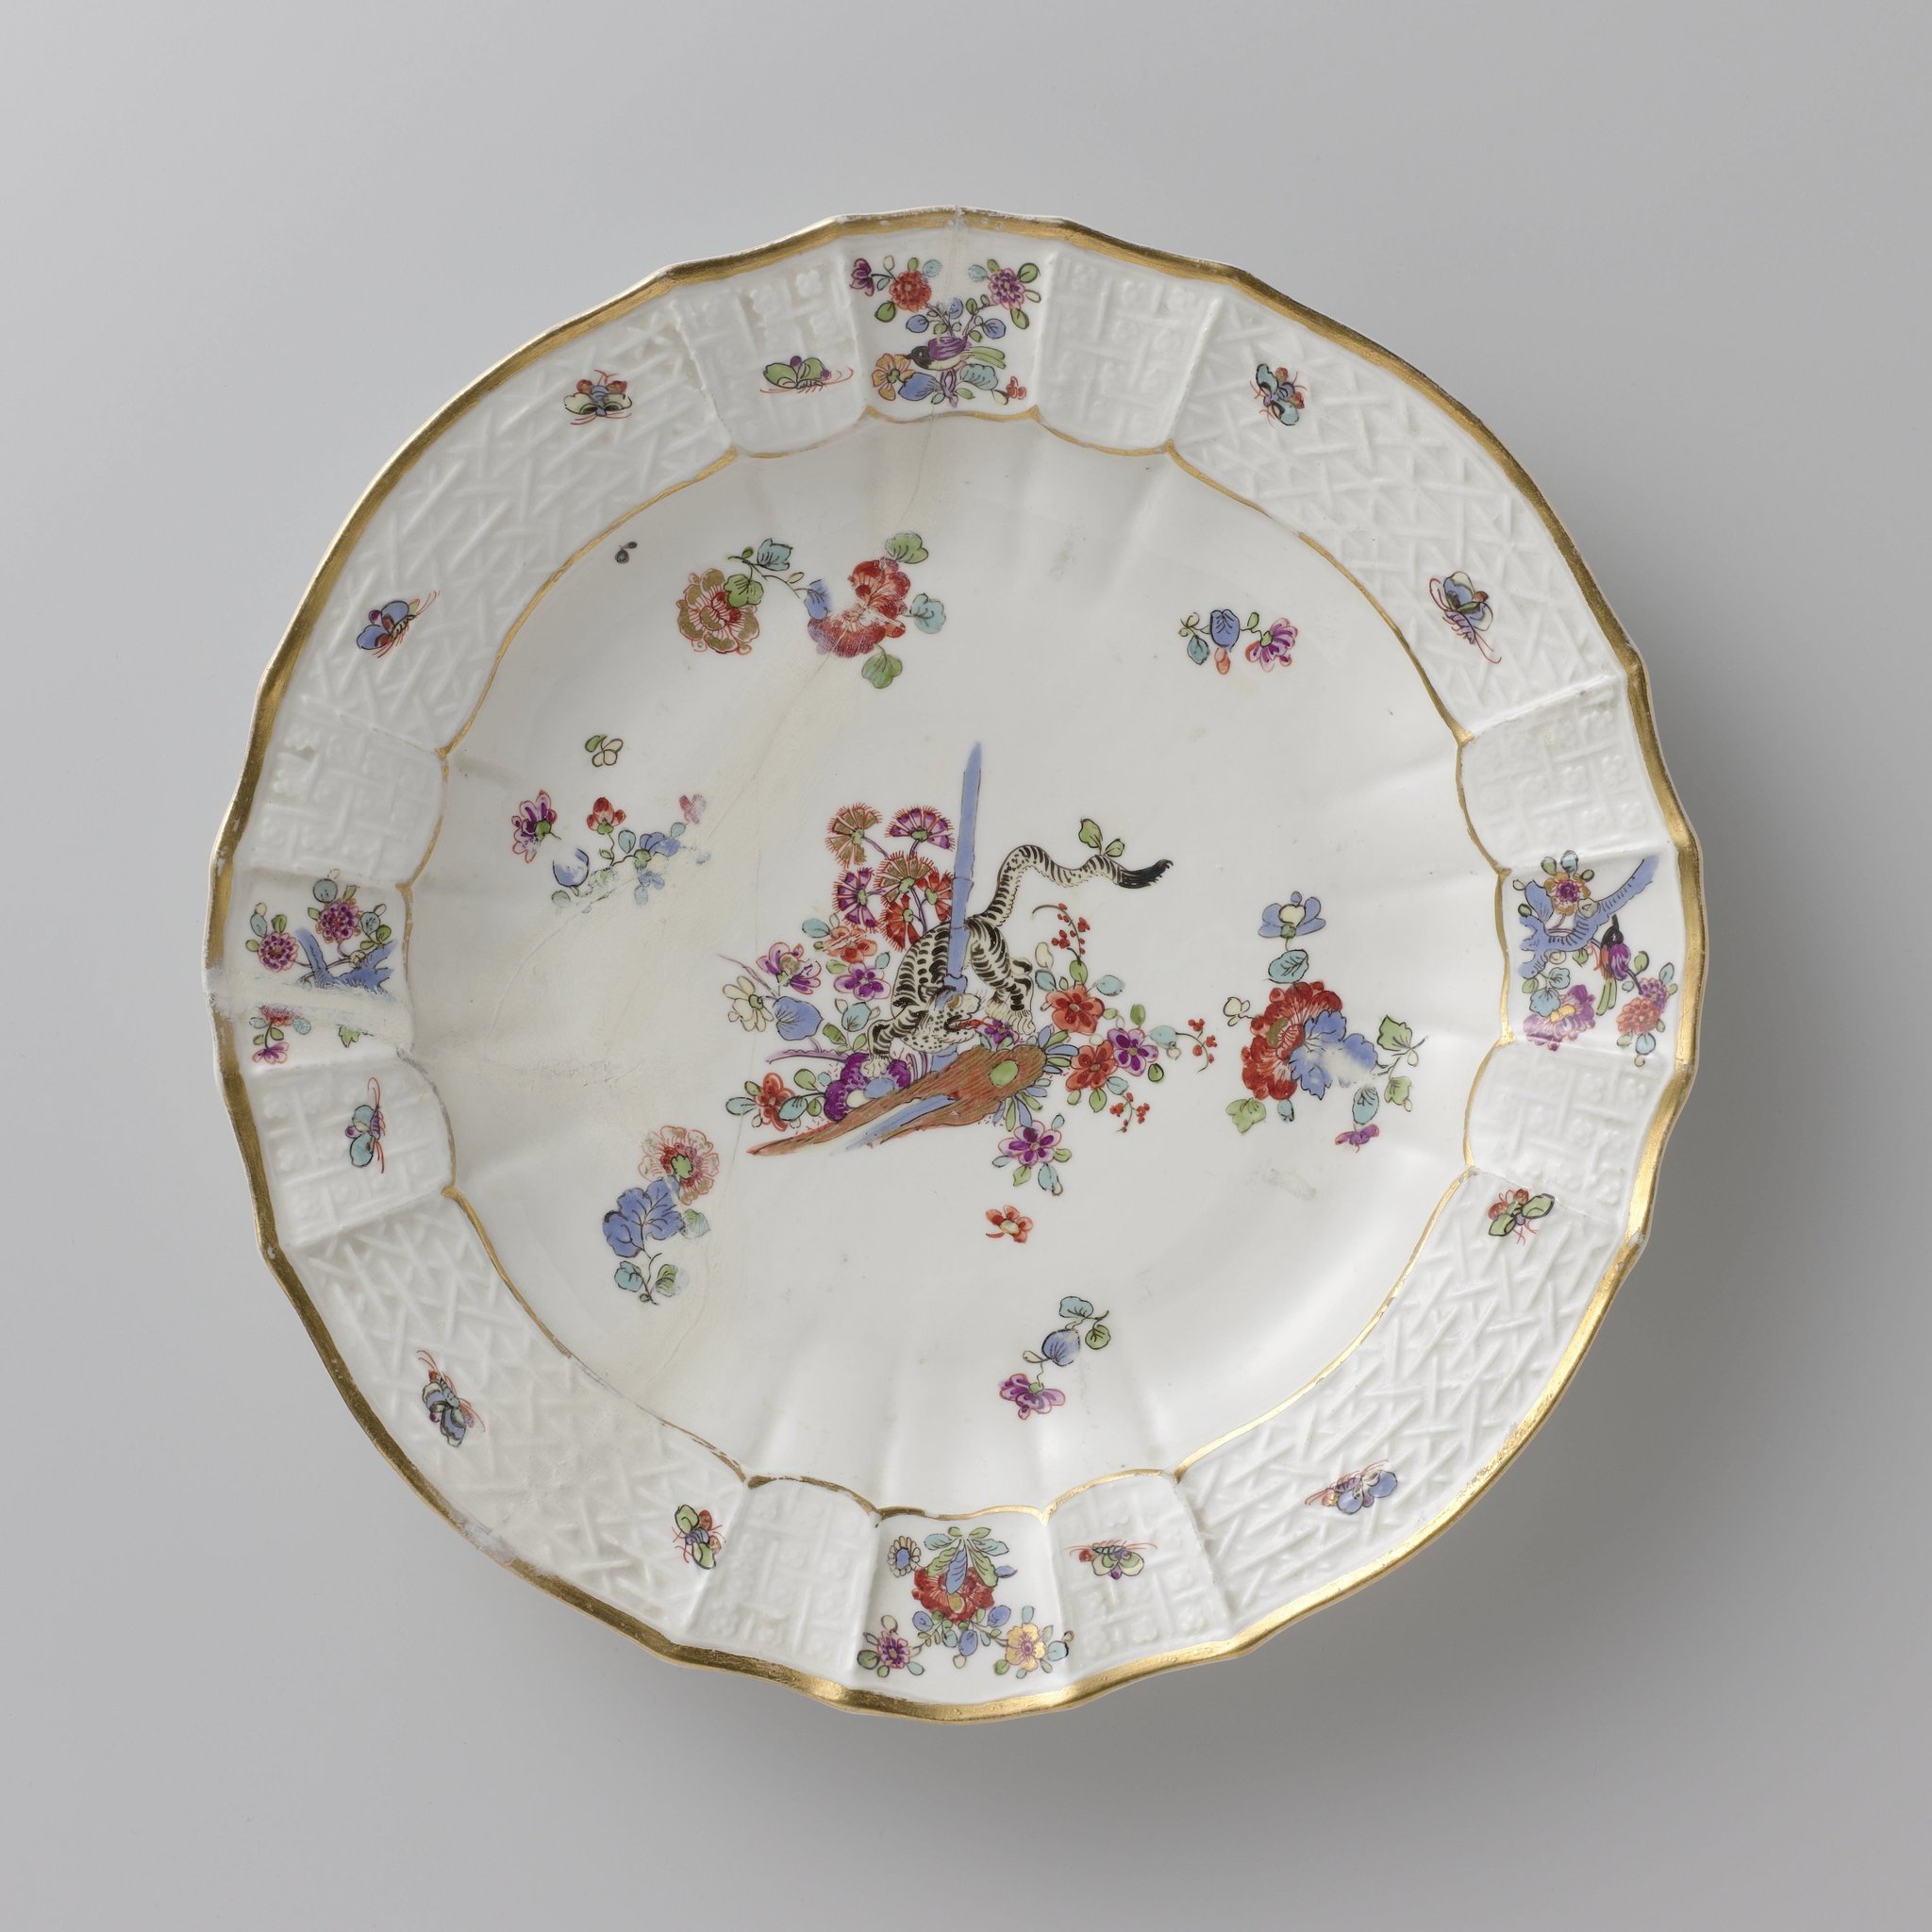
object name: eating drinking utensil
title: Rond bord, veelkleurig beschilderd met een Kakiemon-decor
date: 1740-1745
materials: porcelain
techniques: painted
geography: meissen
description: Rond bord van beschilderd porselein. Het bord is geribd en heeft een geschulpte rand. Het bord is beschilderd met een tijger die om een blauwe bamboestengel tussen bloemen is gedraaid, gestrooide Indianische Blumen, vlinders en takken waarop vogels. De rand is versierd met het 'Altbrandenstein'-patroon. Het bord is gemerkt.